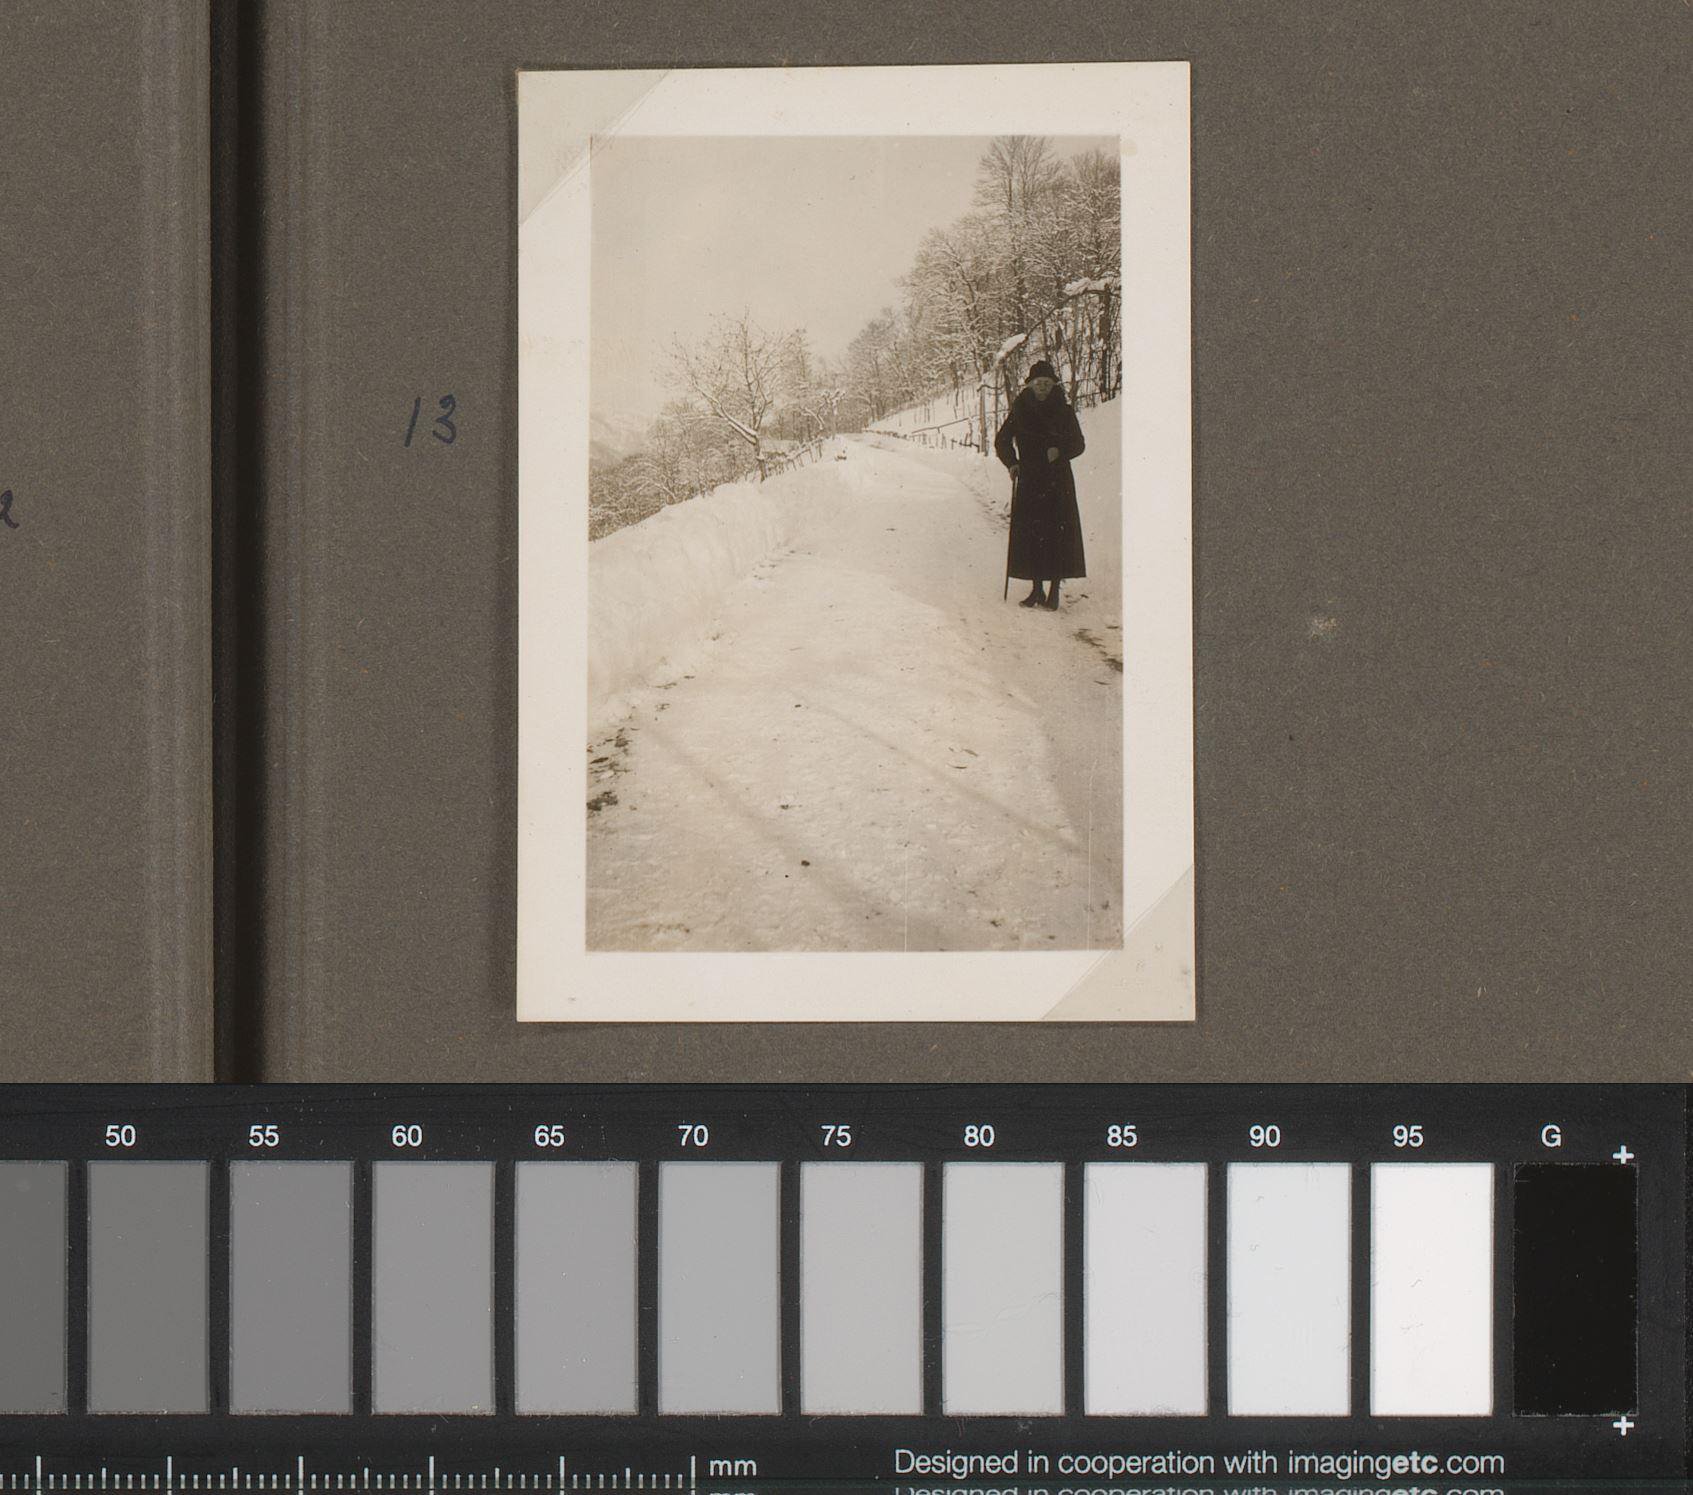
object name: album leaf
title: Vrouw op een weg tussen Campestro en Bettagno, Zwitserland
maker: Anonymous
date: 1933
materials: photographic support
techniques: gelatin silver print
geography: campestro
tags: historical persons - bb - woman, road, path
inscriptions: number: ‘13’